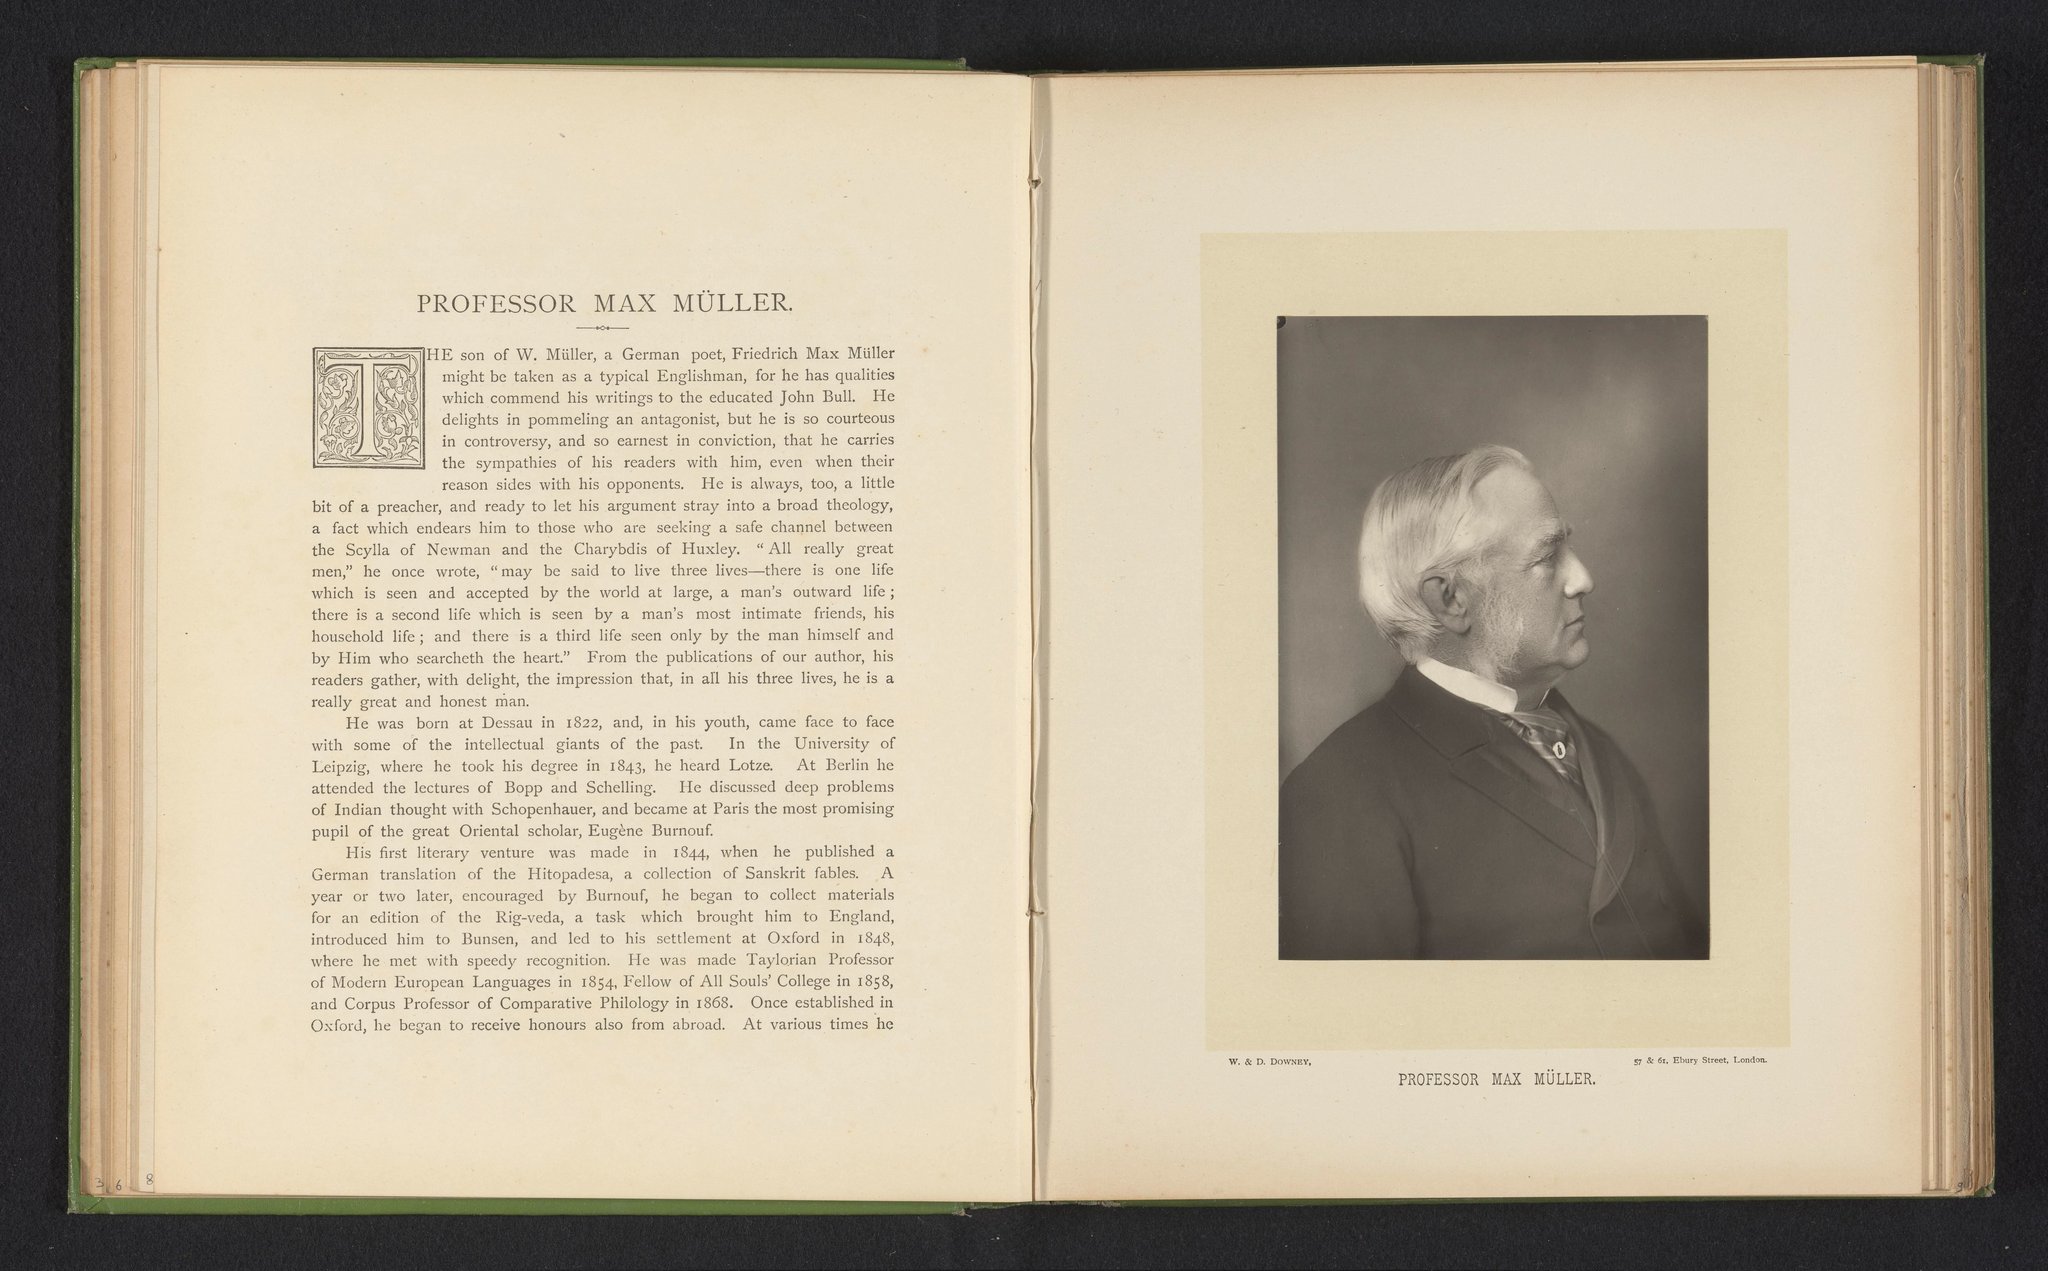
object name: page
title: Professor Max Müller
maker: Anonymous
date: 1893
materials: paper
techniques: woodburytype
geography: london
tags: adult man, historical persons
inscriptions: inscription: ‘57 & 61, Elbury Street, London.’